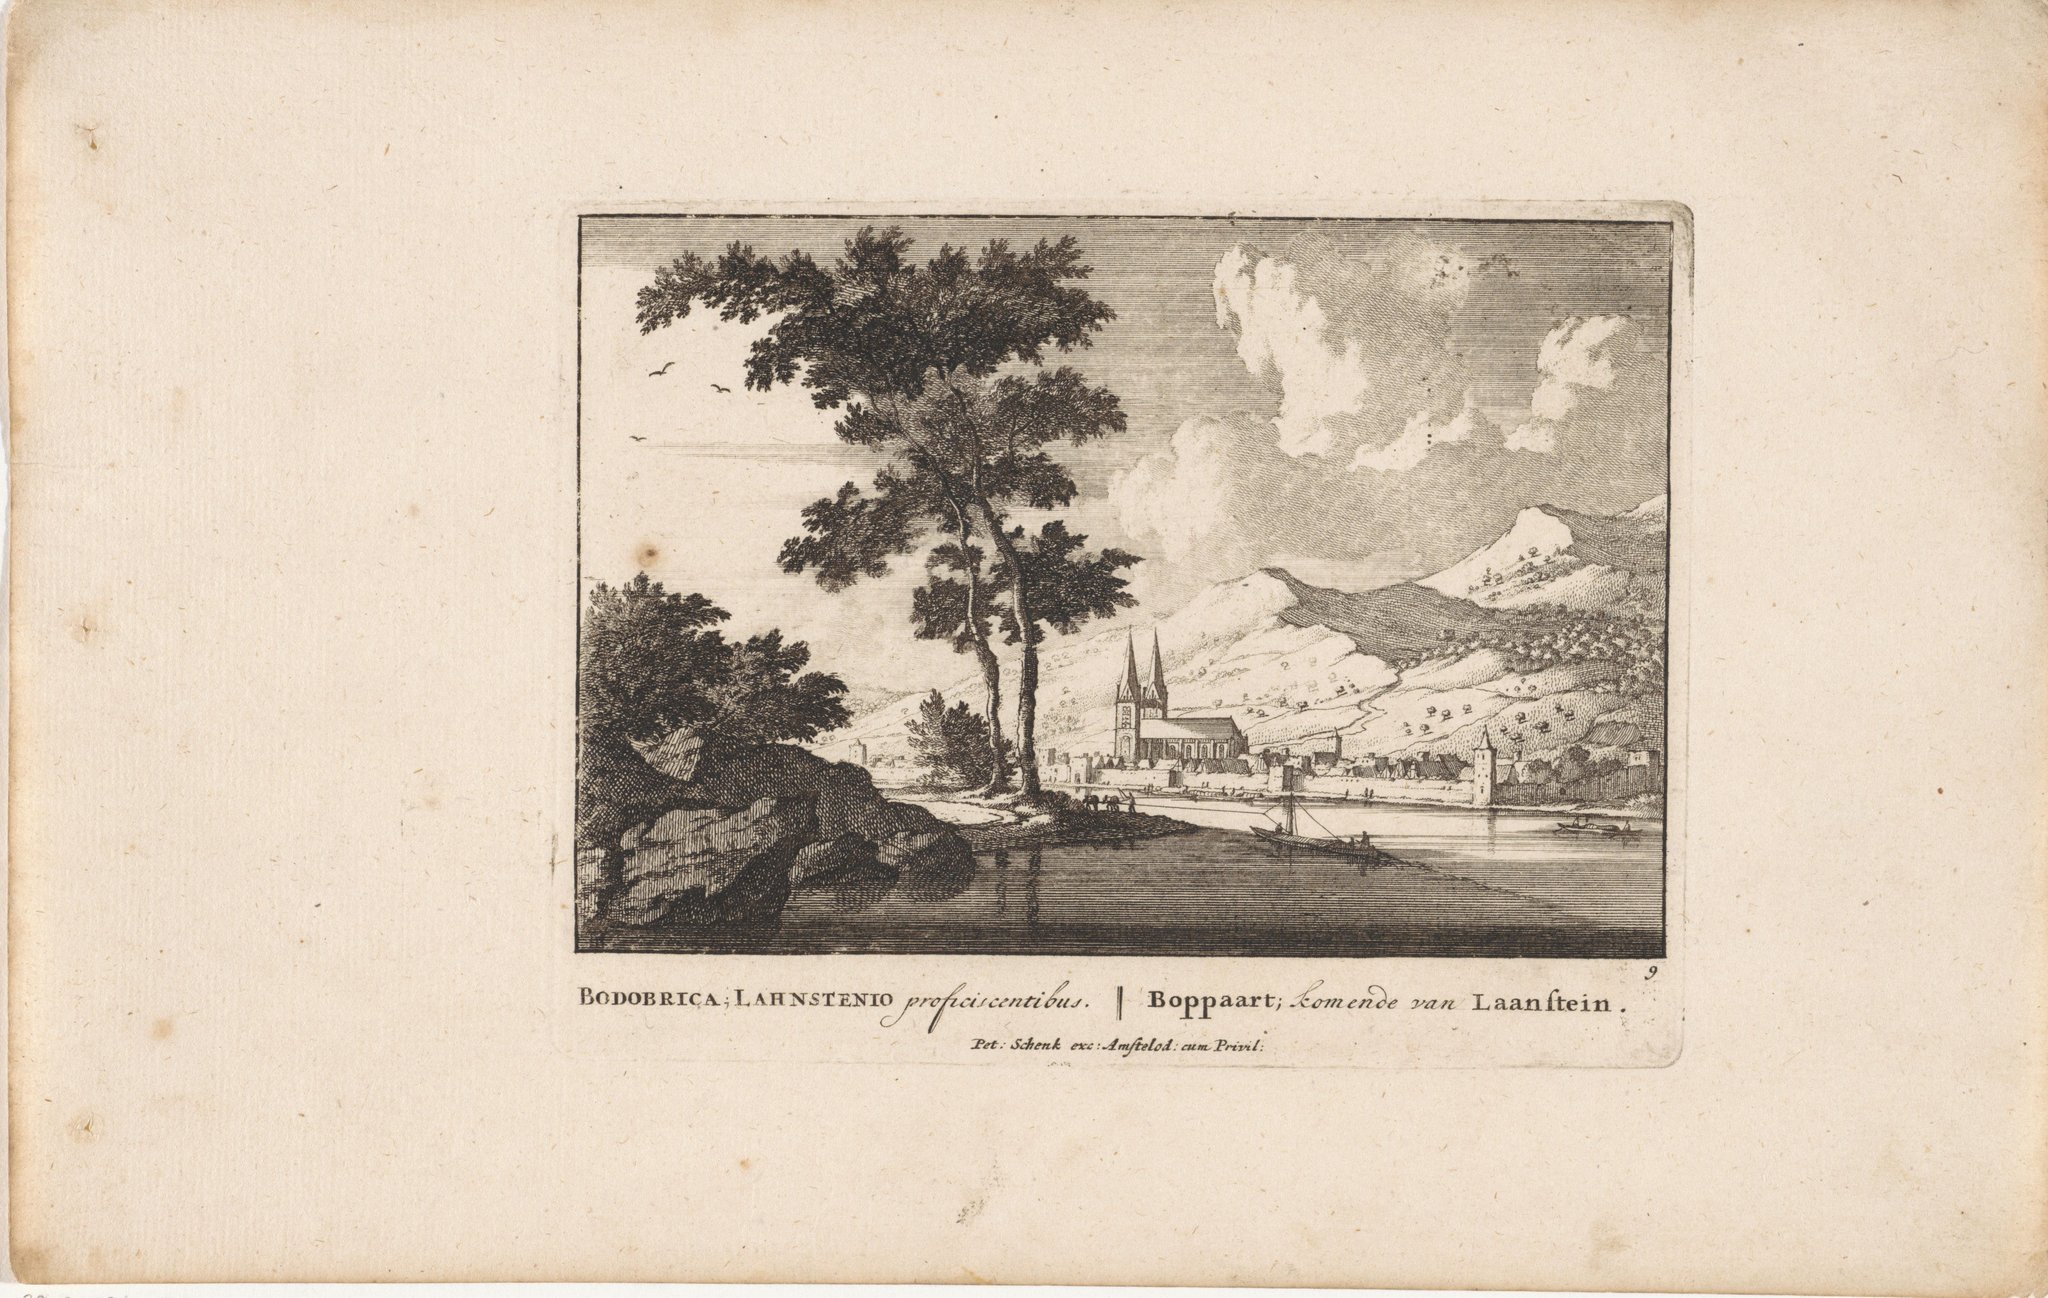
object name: print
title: Admirandorum quadruplex spectaculum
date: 1694-1697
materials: paper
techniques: etching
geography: amsterdam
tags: river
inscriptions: collector's mark: Lugt 2228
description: Gezicht op Boppard aan de Rijn. Prent uit een serie van 71 prenten met Rijnlandschappen, gezichten op vorstelijke paleizen en stadsgezichten uit Den Haag en Amsterdam.